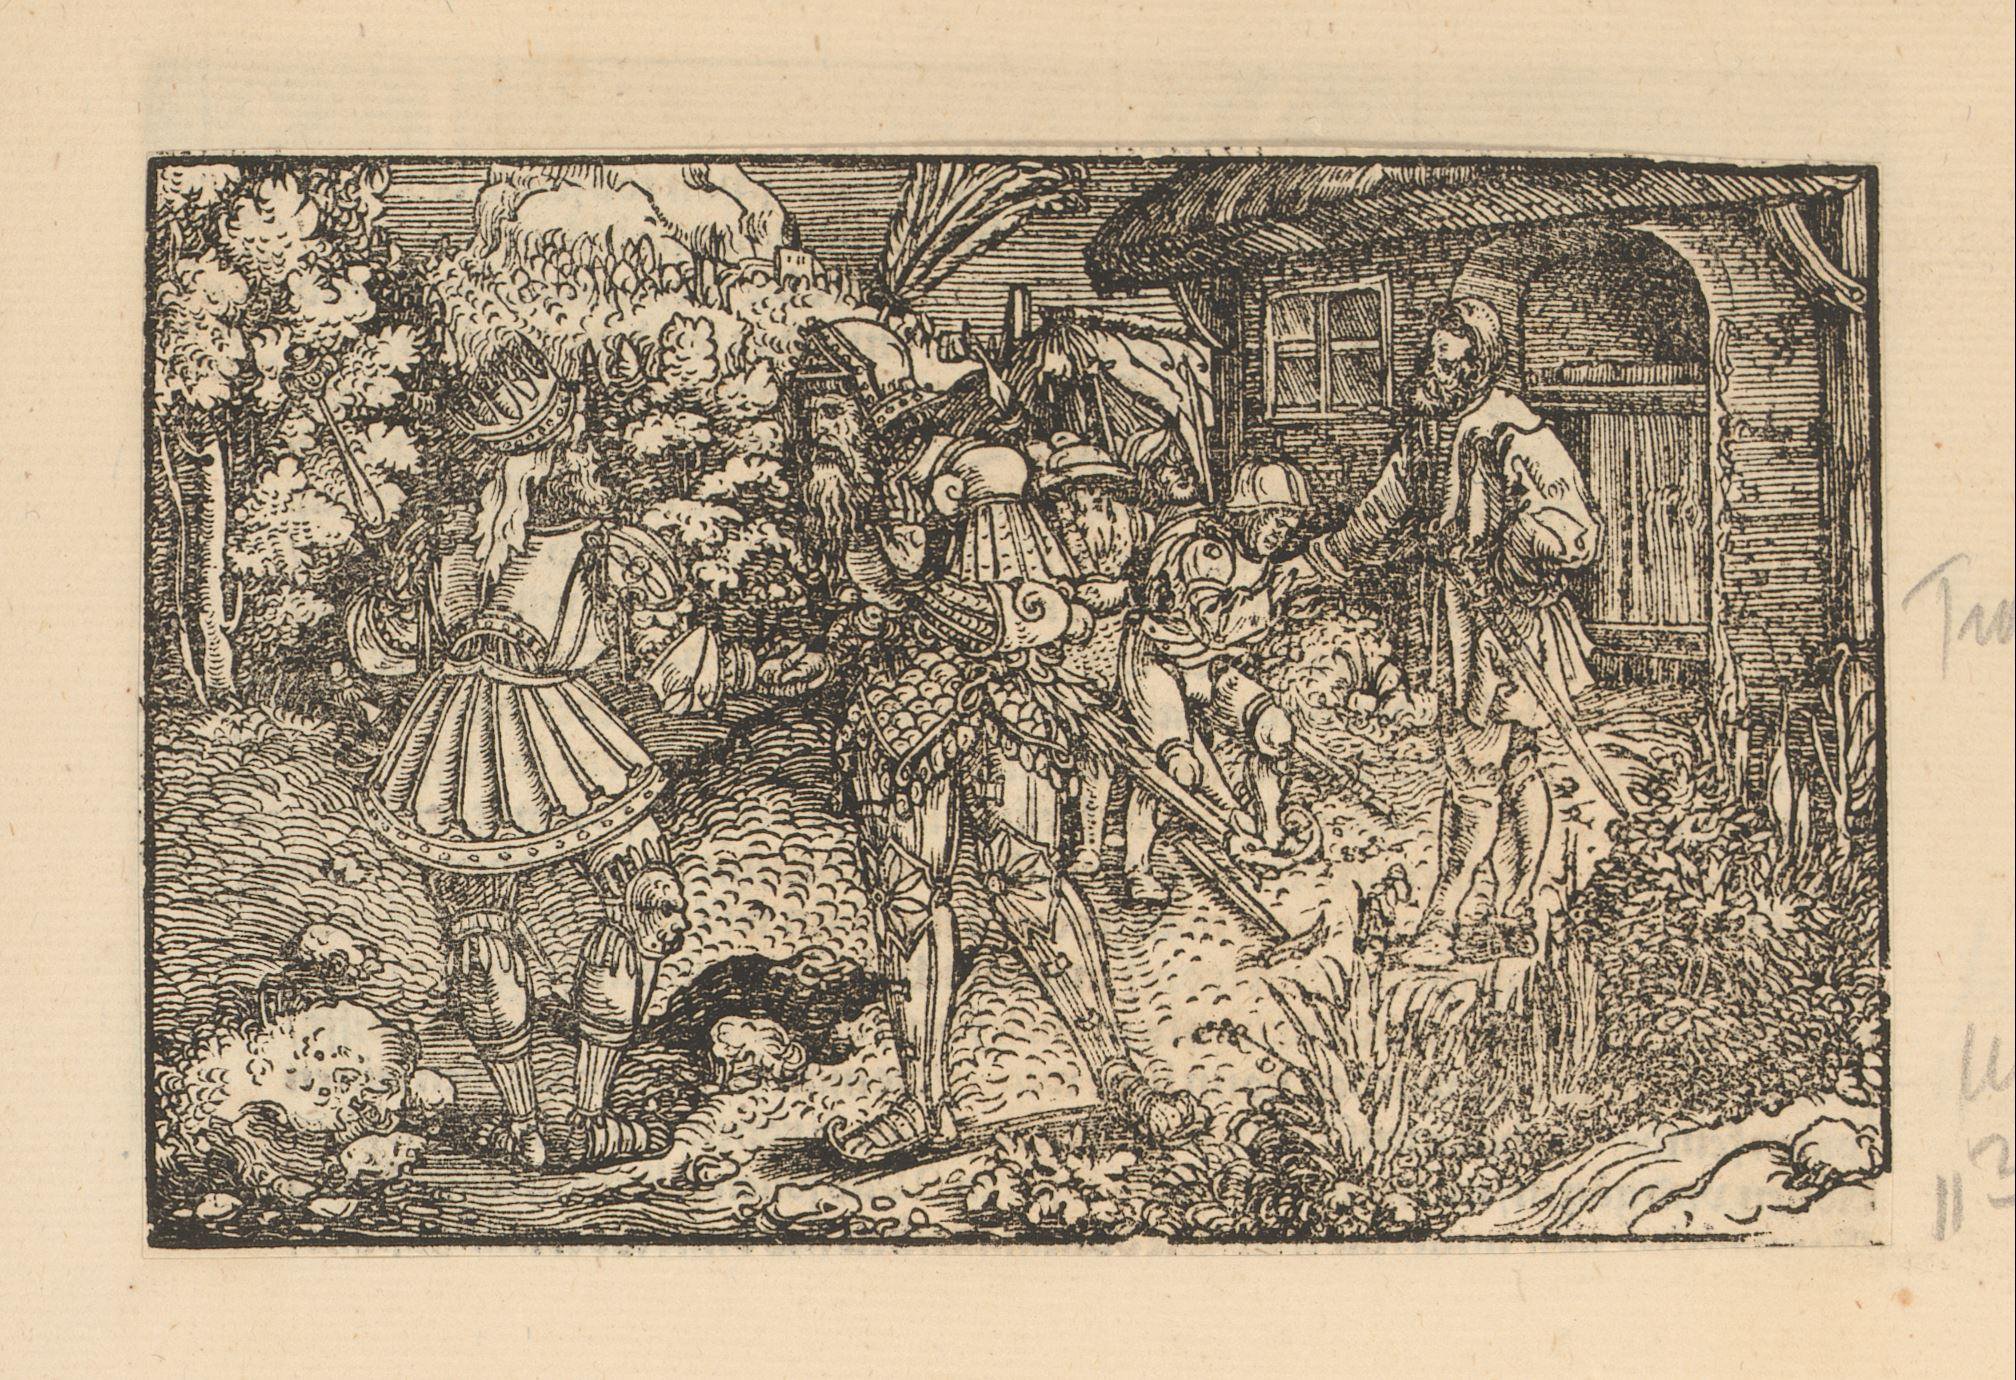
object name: print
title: Gewapende mannen schudden elkaar de hand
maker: Anonymous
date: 1514-1532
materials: paper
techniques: letterpress printing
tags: violent death by blows, kicks, pricks, etc., meeting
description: Deze prent is gebruikt in: Petrarca, Francesco. Von der Artzney bayder Glück, des guten und widerwertigen: unnd weß sich ain yeder inn Gelück und Unglück halten sol (...). Augsburg: Heinrich Steiner, 1532. Deze uitgave is ook bekend onder de titel 'Trostspiegel in Glück und Unglück'.